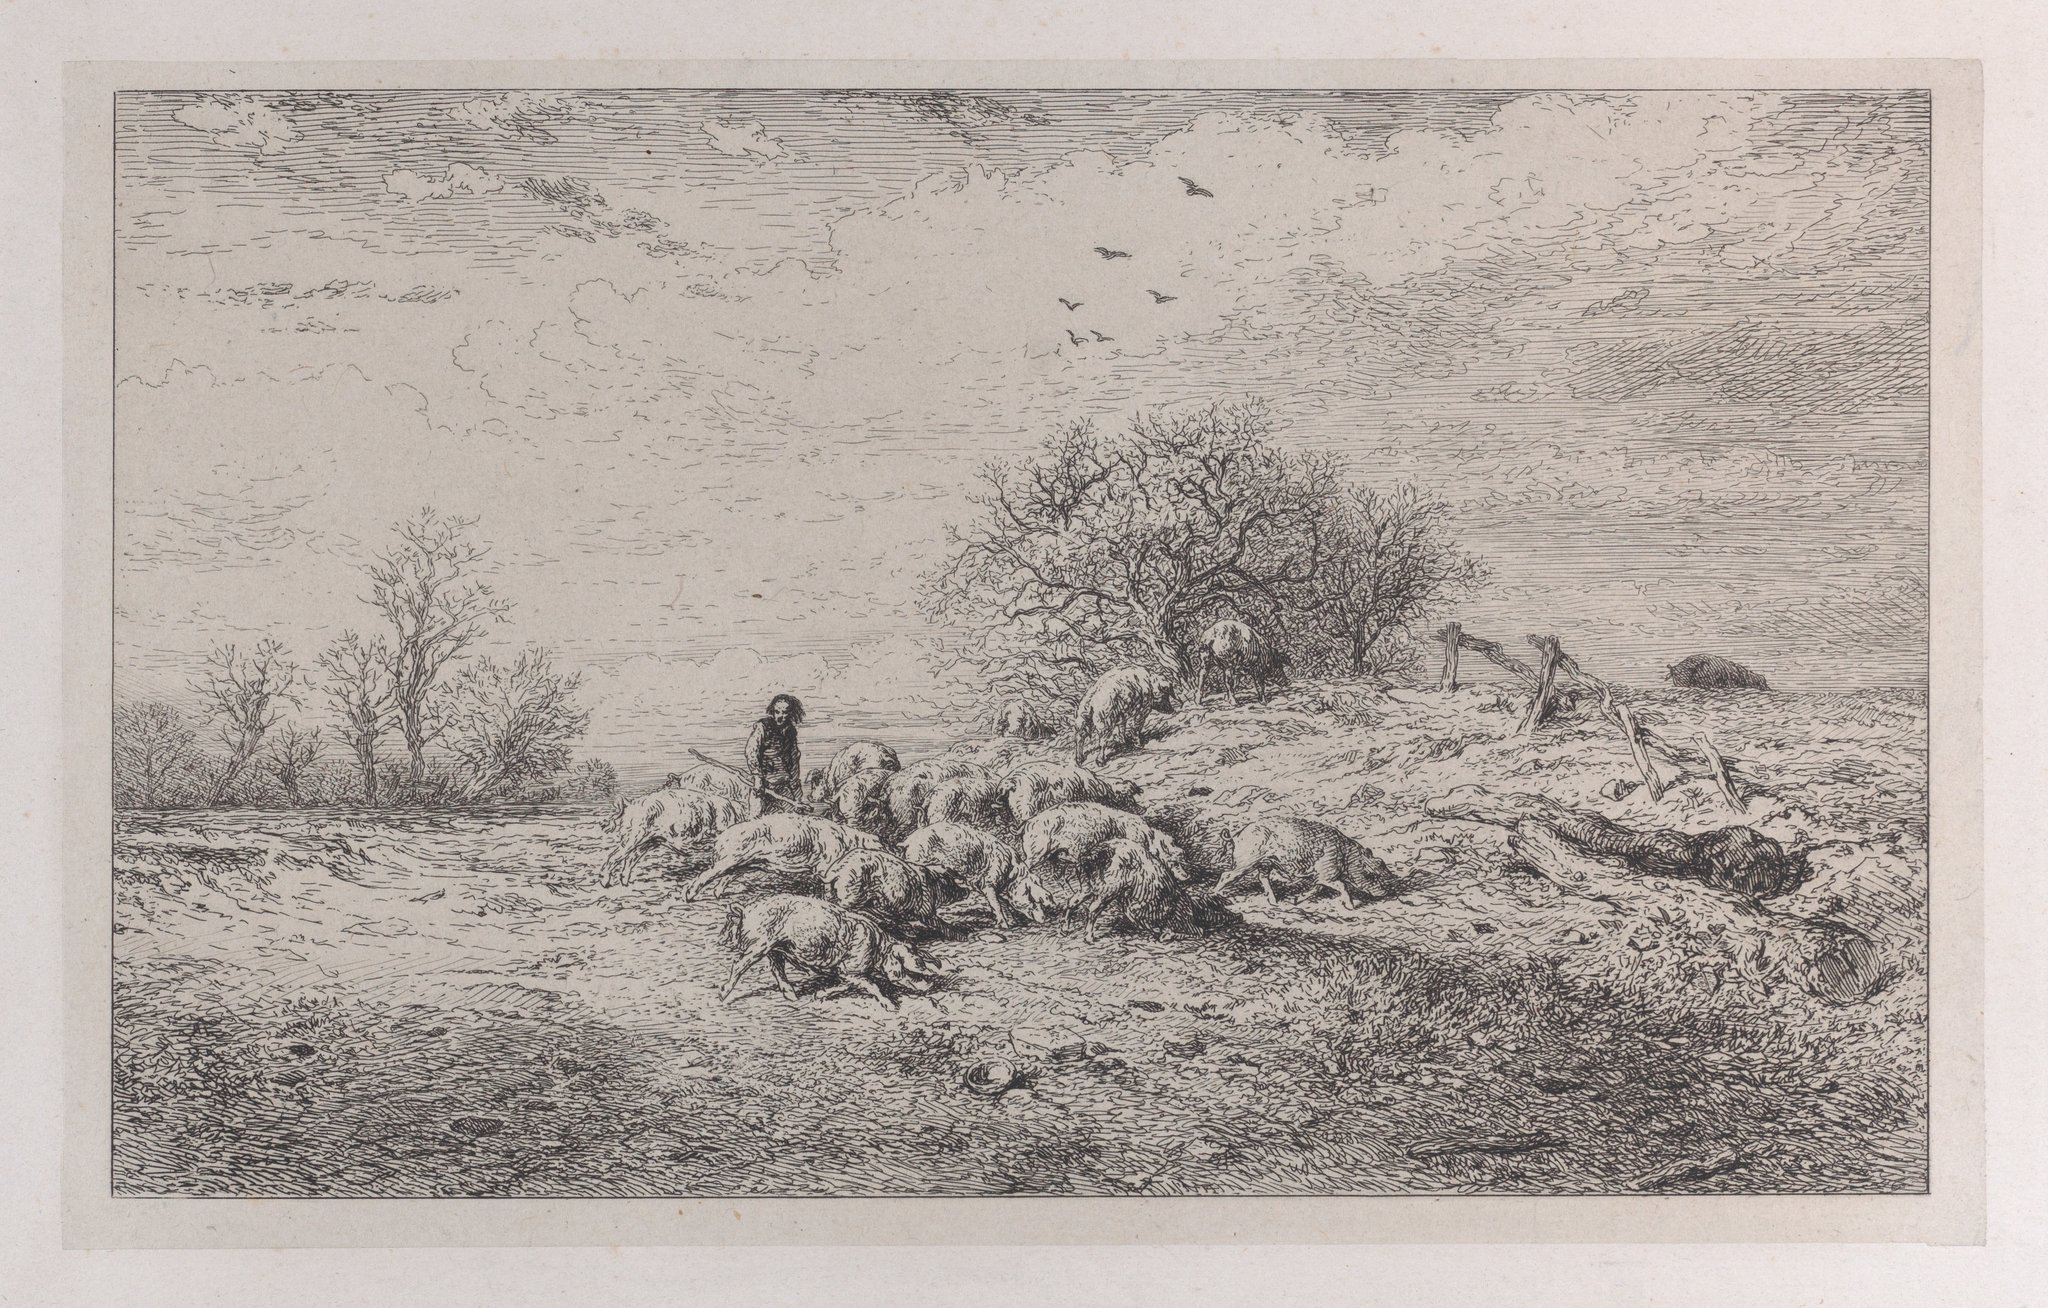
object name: print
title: The Truffle Hunter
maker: charles émile jacque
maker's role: artist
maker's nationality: french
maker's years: 1813-1894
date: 1845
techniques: etching